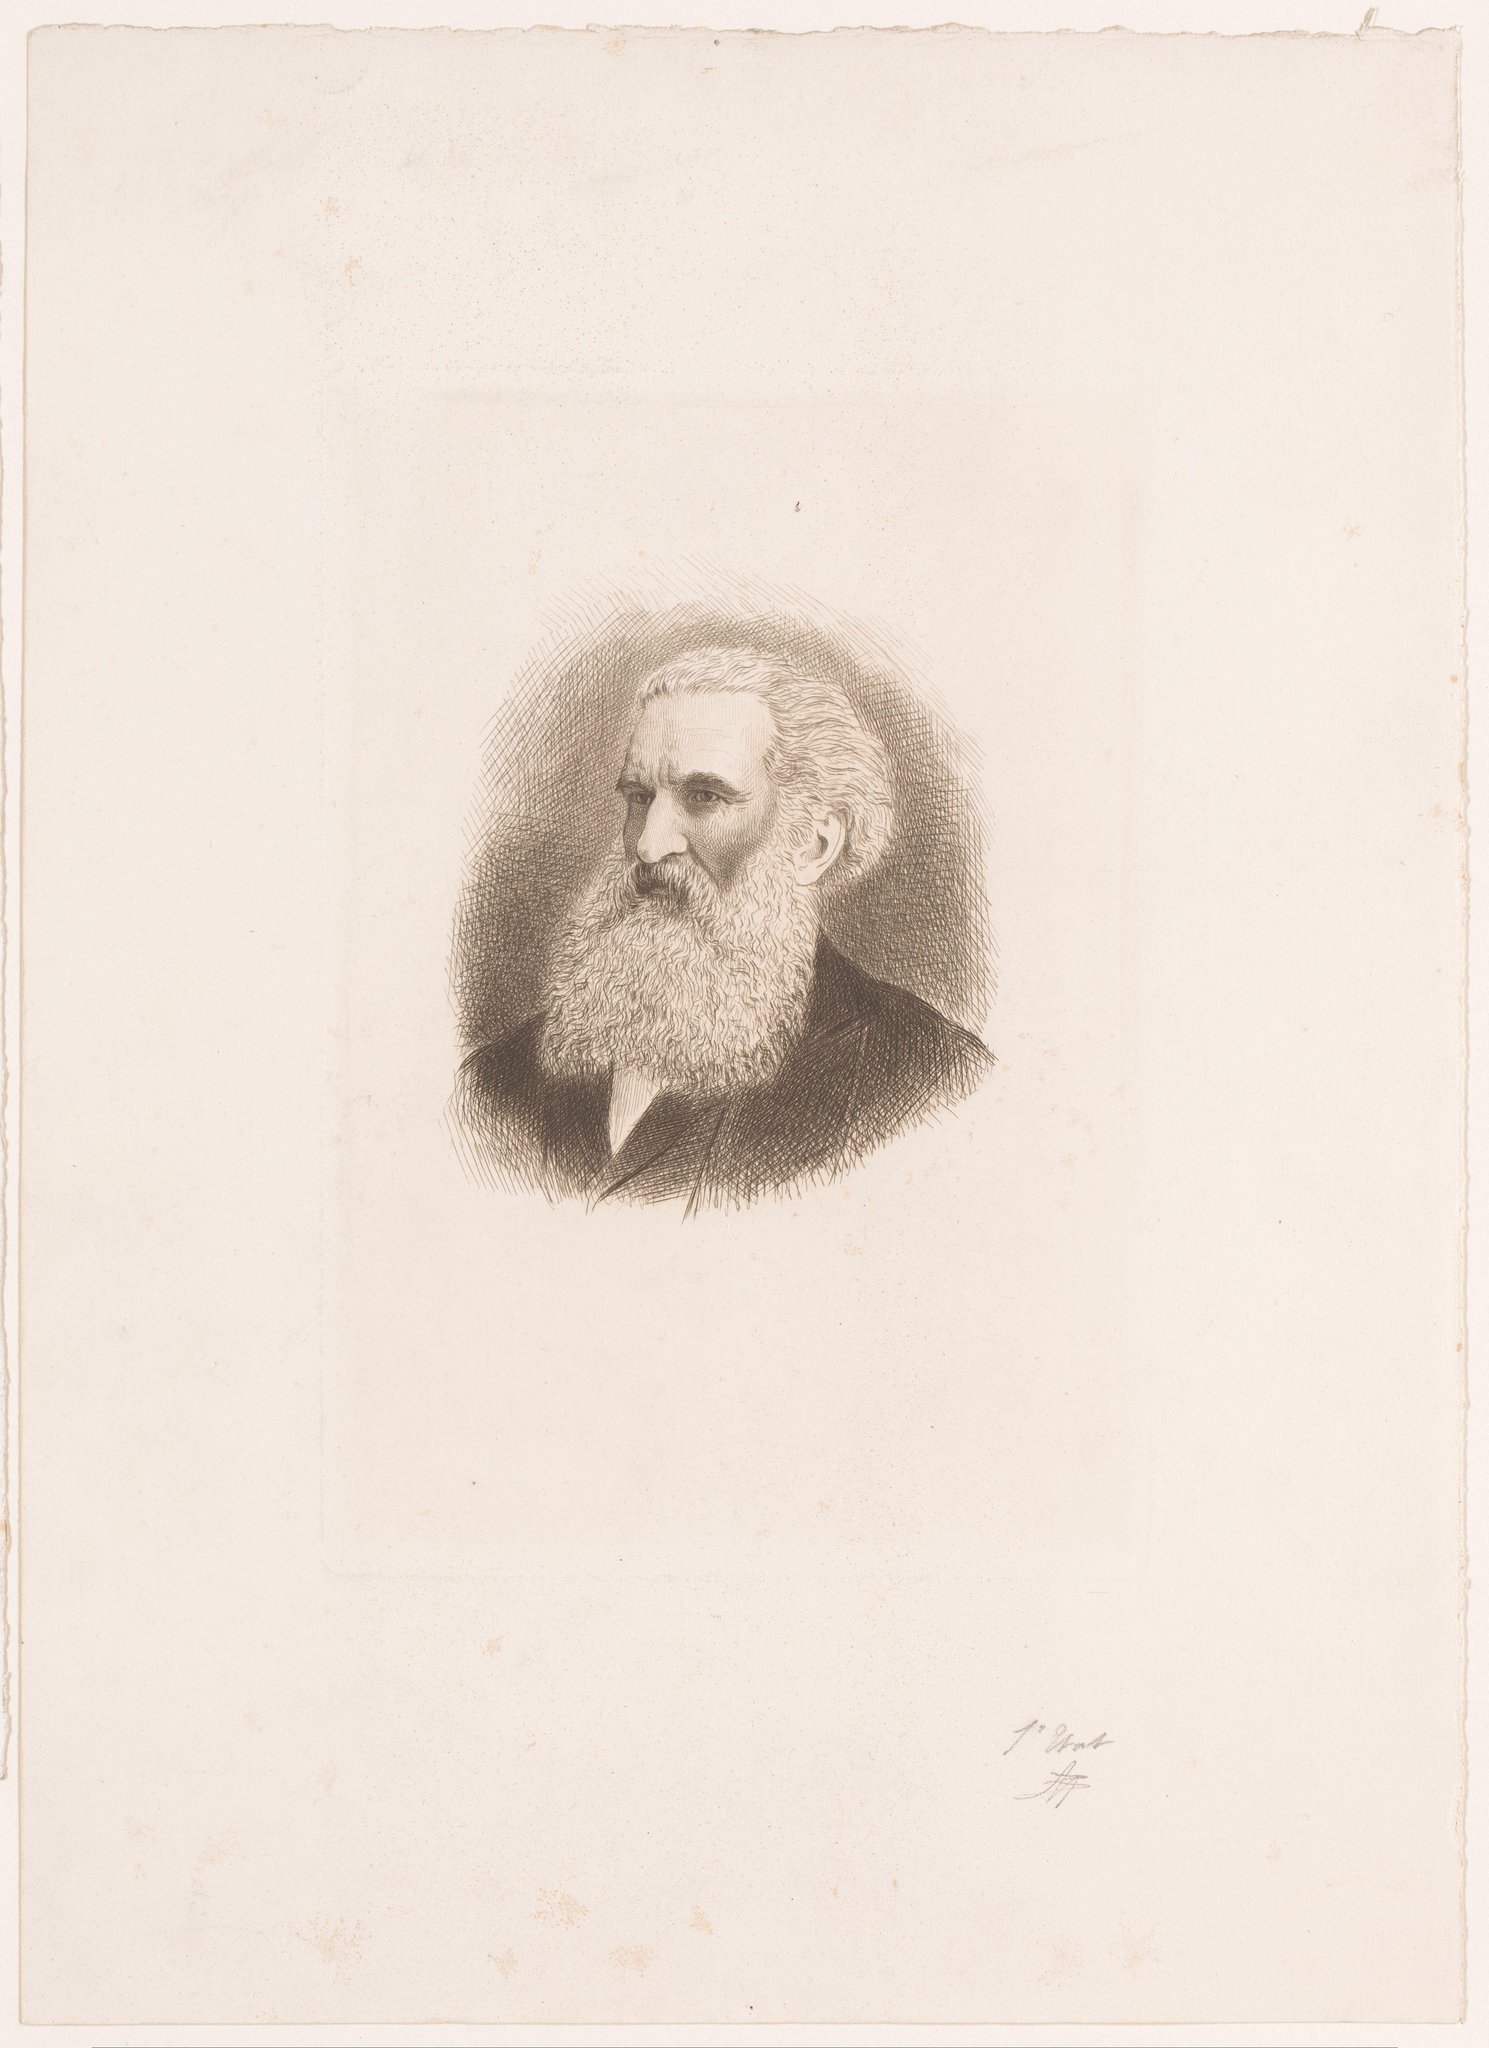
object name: print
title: Portret van een onbekende man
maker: jean baptiste pierre michiels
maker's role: print maker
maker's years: 1821-1890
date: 1831-1890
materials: paper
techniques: etching, intaglio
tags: adult man, historical persons, beard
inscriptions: inscription: ‘1e Etat’, collector's mark: Lugt 2228